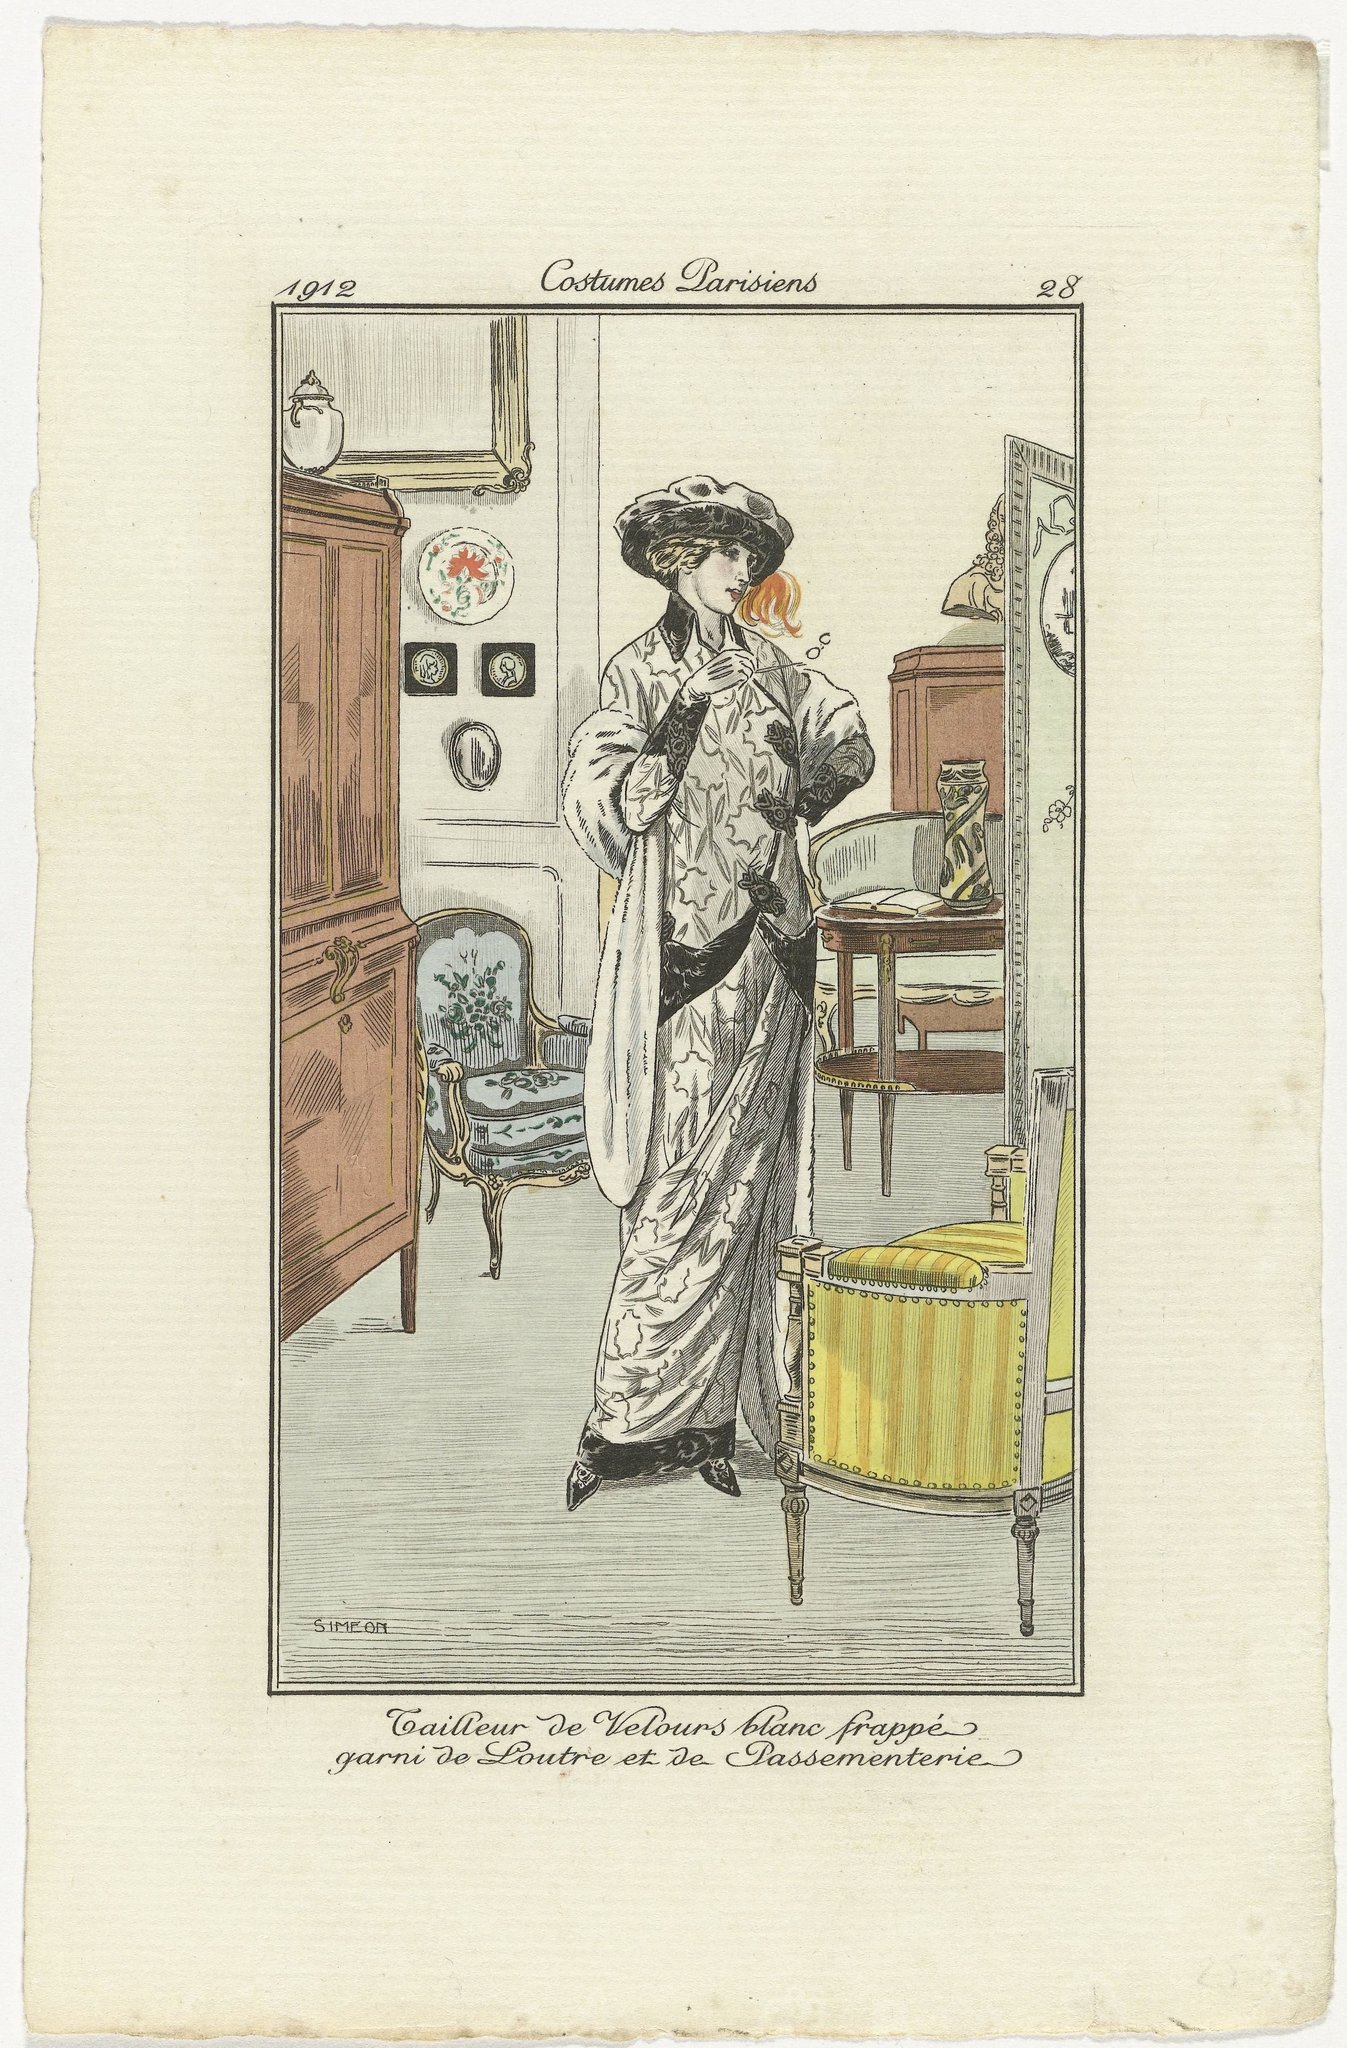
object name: fashion print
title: Journal des Dames et des Modes, Costumes Parisiens, 1912, No. 28 : Tailleur de Velours (...)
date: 1912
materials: paper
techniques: engraving, hand coloring, pochoir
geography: paris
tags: clothing for the upper part of the body (+ women's clothes), ornamental parts of clothing (+ women's clothes), ensembles of pieces of clothing (suit) (+ women's clothes), ornamental parts of clothing (+ fur used for clothes), head-gear (+ women's clothes), fashion plates, skirt (+ women's clothes), clothing for the upper part of the body (+ fur used for clothes), living-room, parlour, sitting-room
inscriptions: title: ‘Costumes Parisiens’, caption: ‘Tailleur de Velours blanc frappé garni de Loutre et de Passementerie’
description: Vrouw in intereieur, in een mantelpak van wit geperst fluweel versierd met otterbont en passementerie. Bijpassende hoed. Prent uit het modetijdschrift Journal des Dames et des Modes (1912-1914).